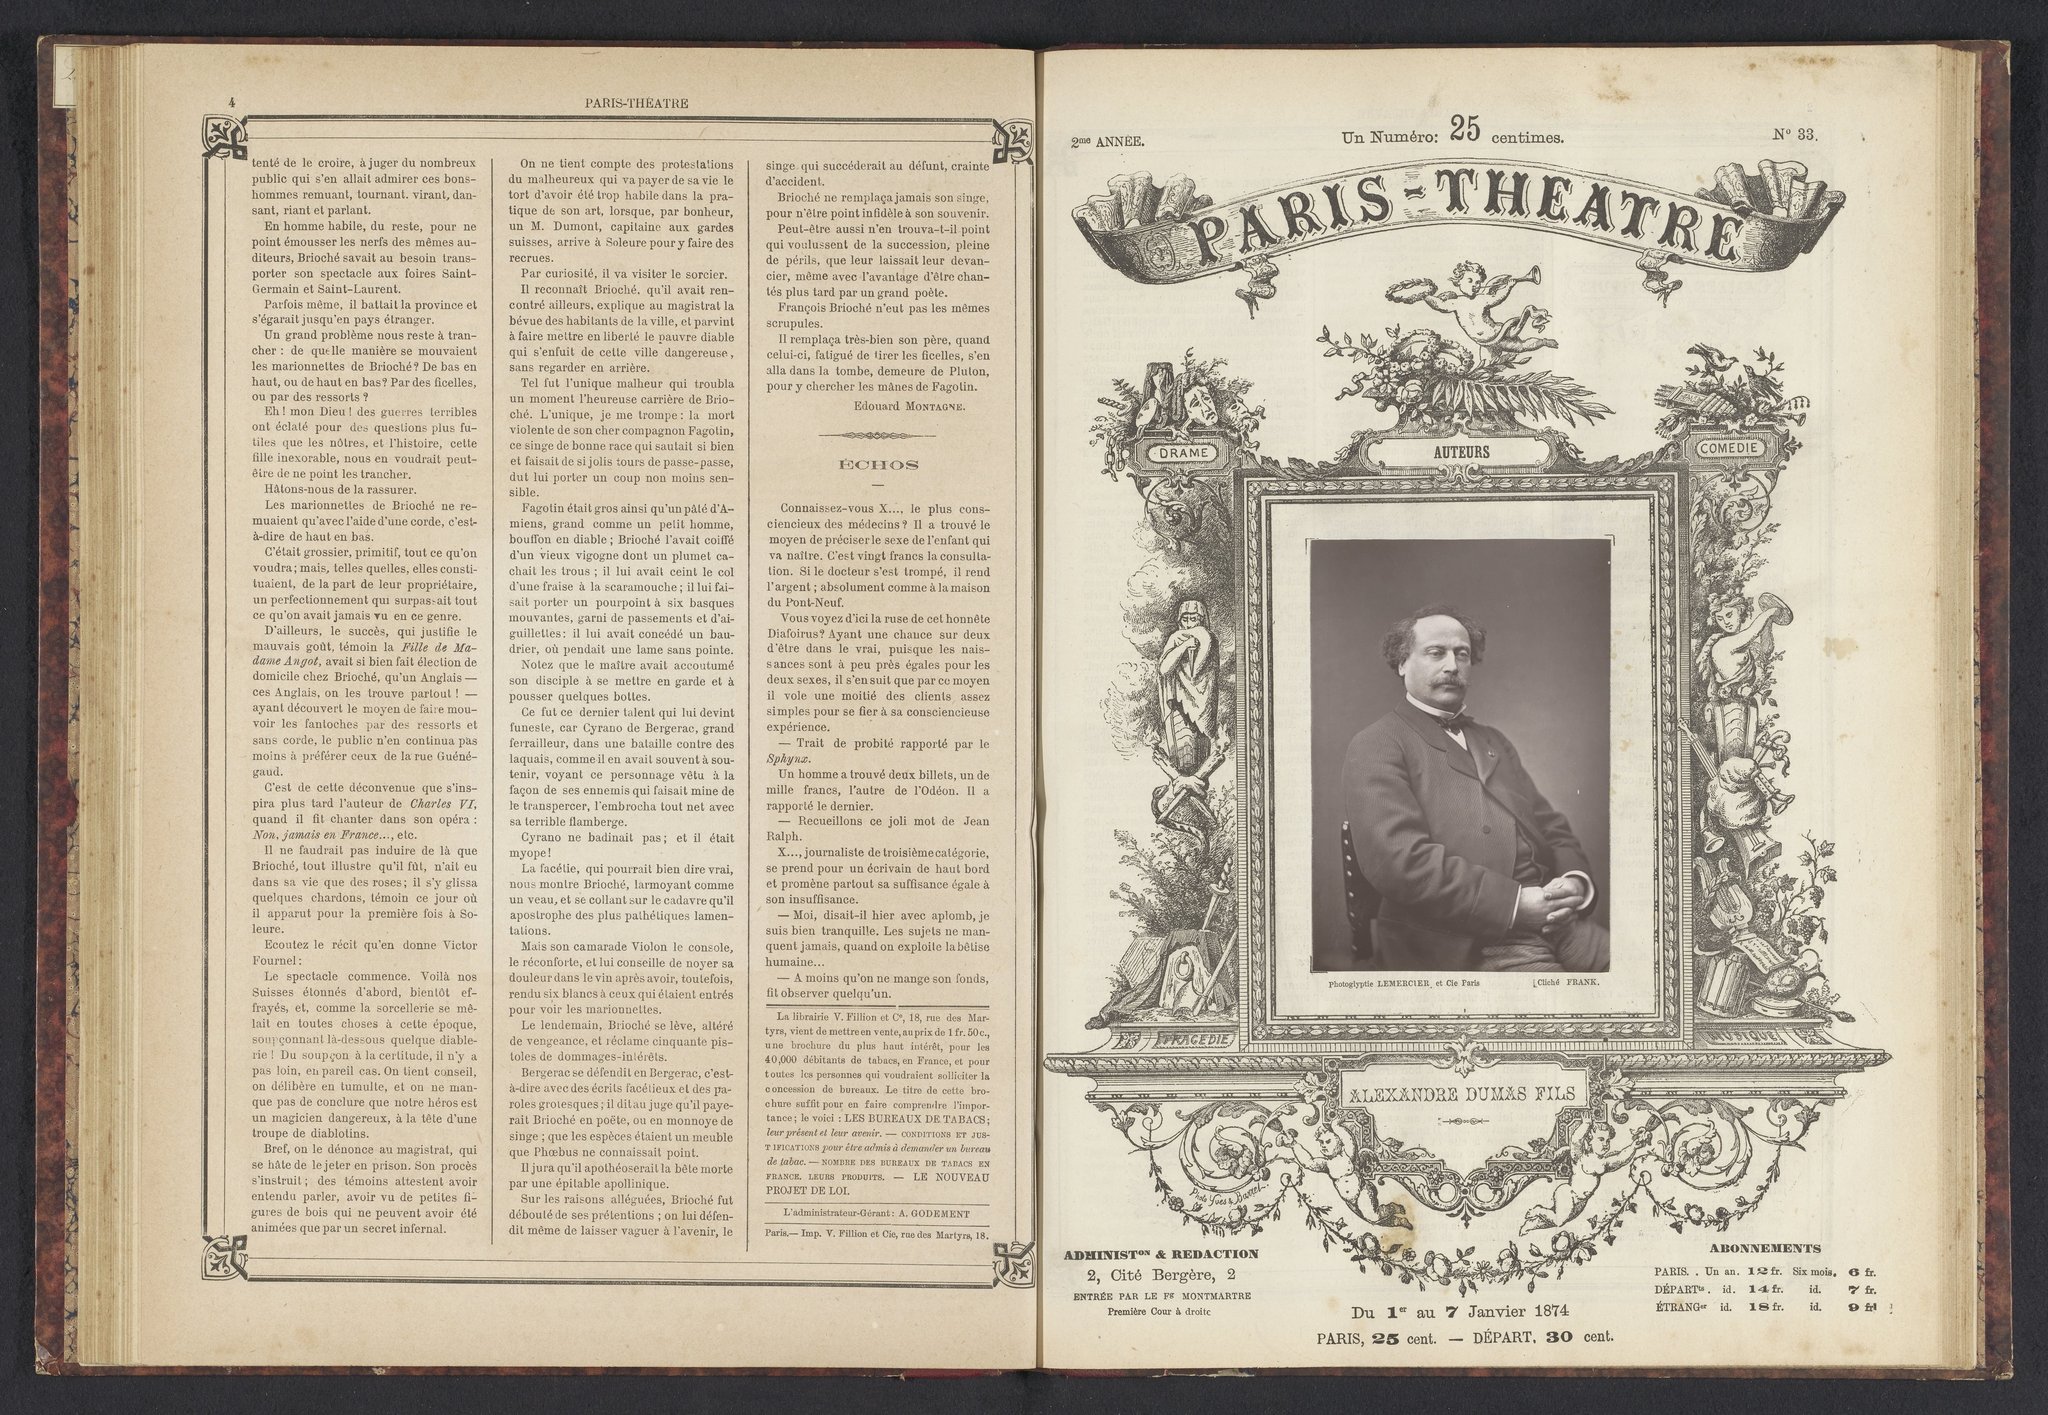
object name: page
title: Alexandre Dumas fils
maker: frank (fotograaf)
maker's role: fotograaf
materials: paper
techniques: woodburytype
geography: paris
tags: paris, portrait of artiste (dancer, actor, etc.)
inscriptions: number: ‘No 33.’, inscription: ‘Du 1er au 7 Janvier 1874’